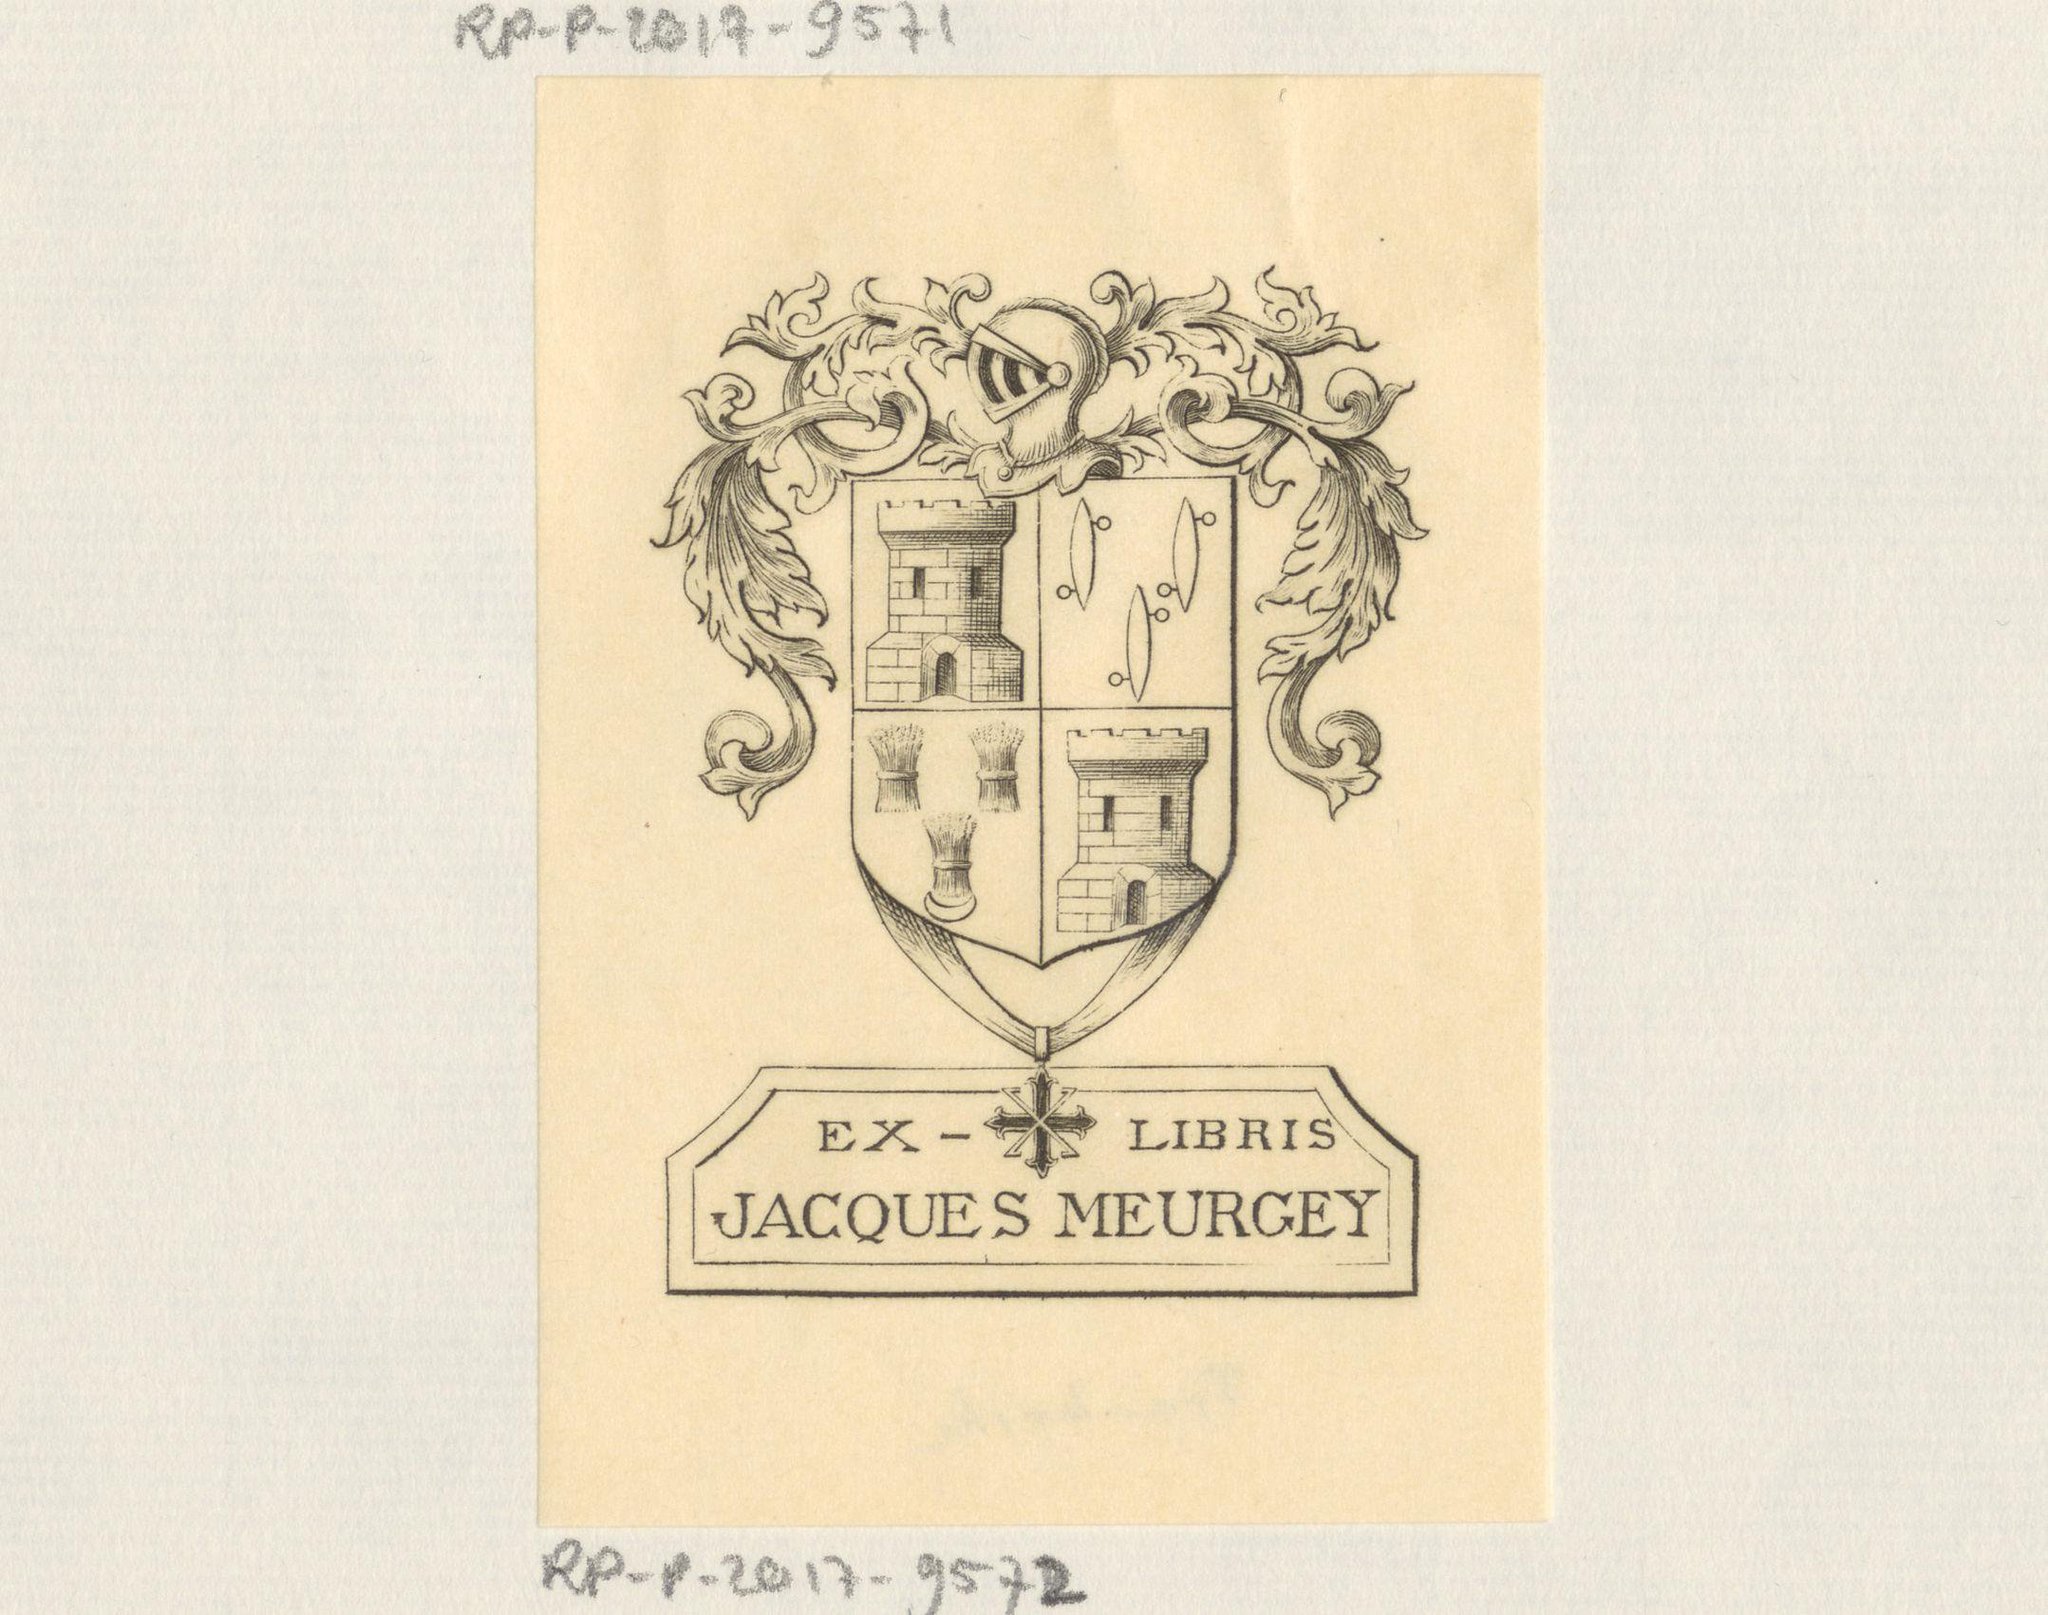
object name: bookplate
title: Ex libris van Jacques Meurgey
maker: Anonymous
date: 1901-1973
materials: paper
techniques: engraving, etching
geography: france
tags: armorial bearing, heraldry